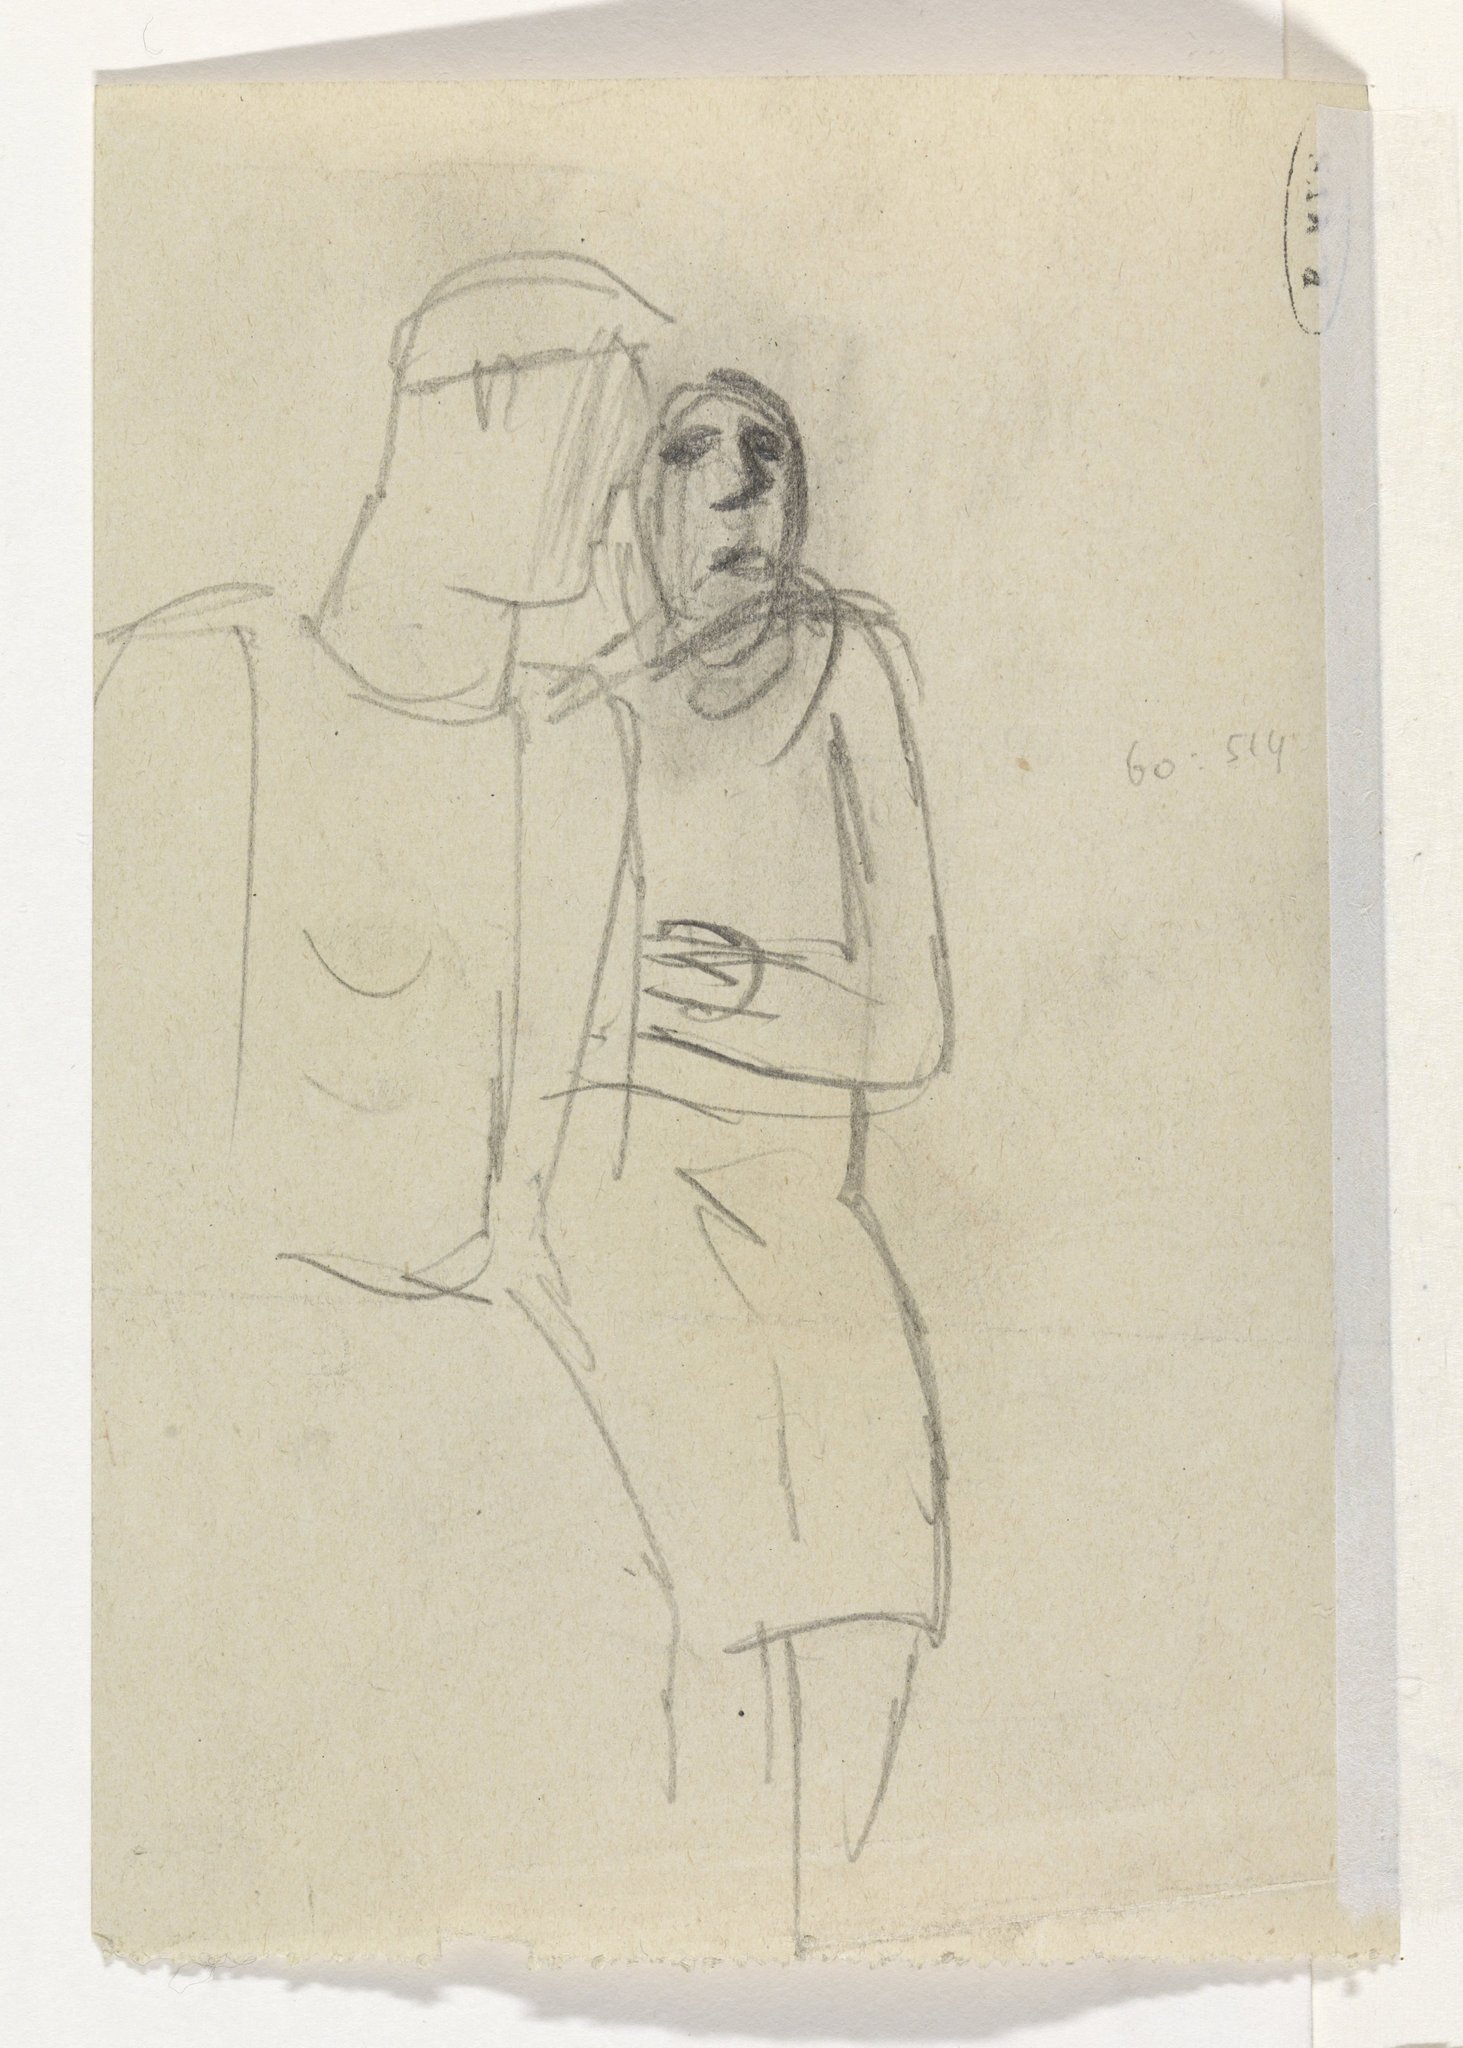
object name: drawing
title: Staand koppel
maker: leo gestel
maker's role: draughtsman, print maker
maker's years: 1881-1941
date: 1891-1941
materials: paper, pencil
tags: couple of lovers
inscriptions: collector's mark: Lugt 2228